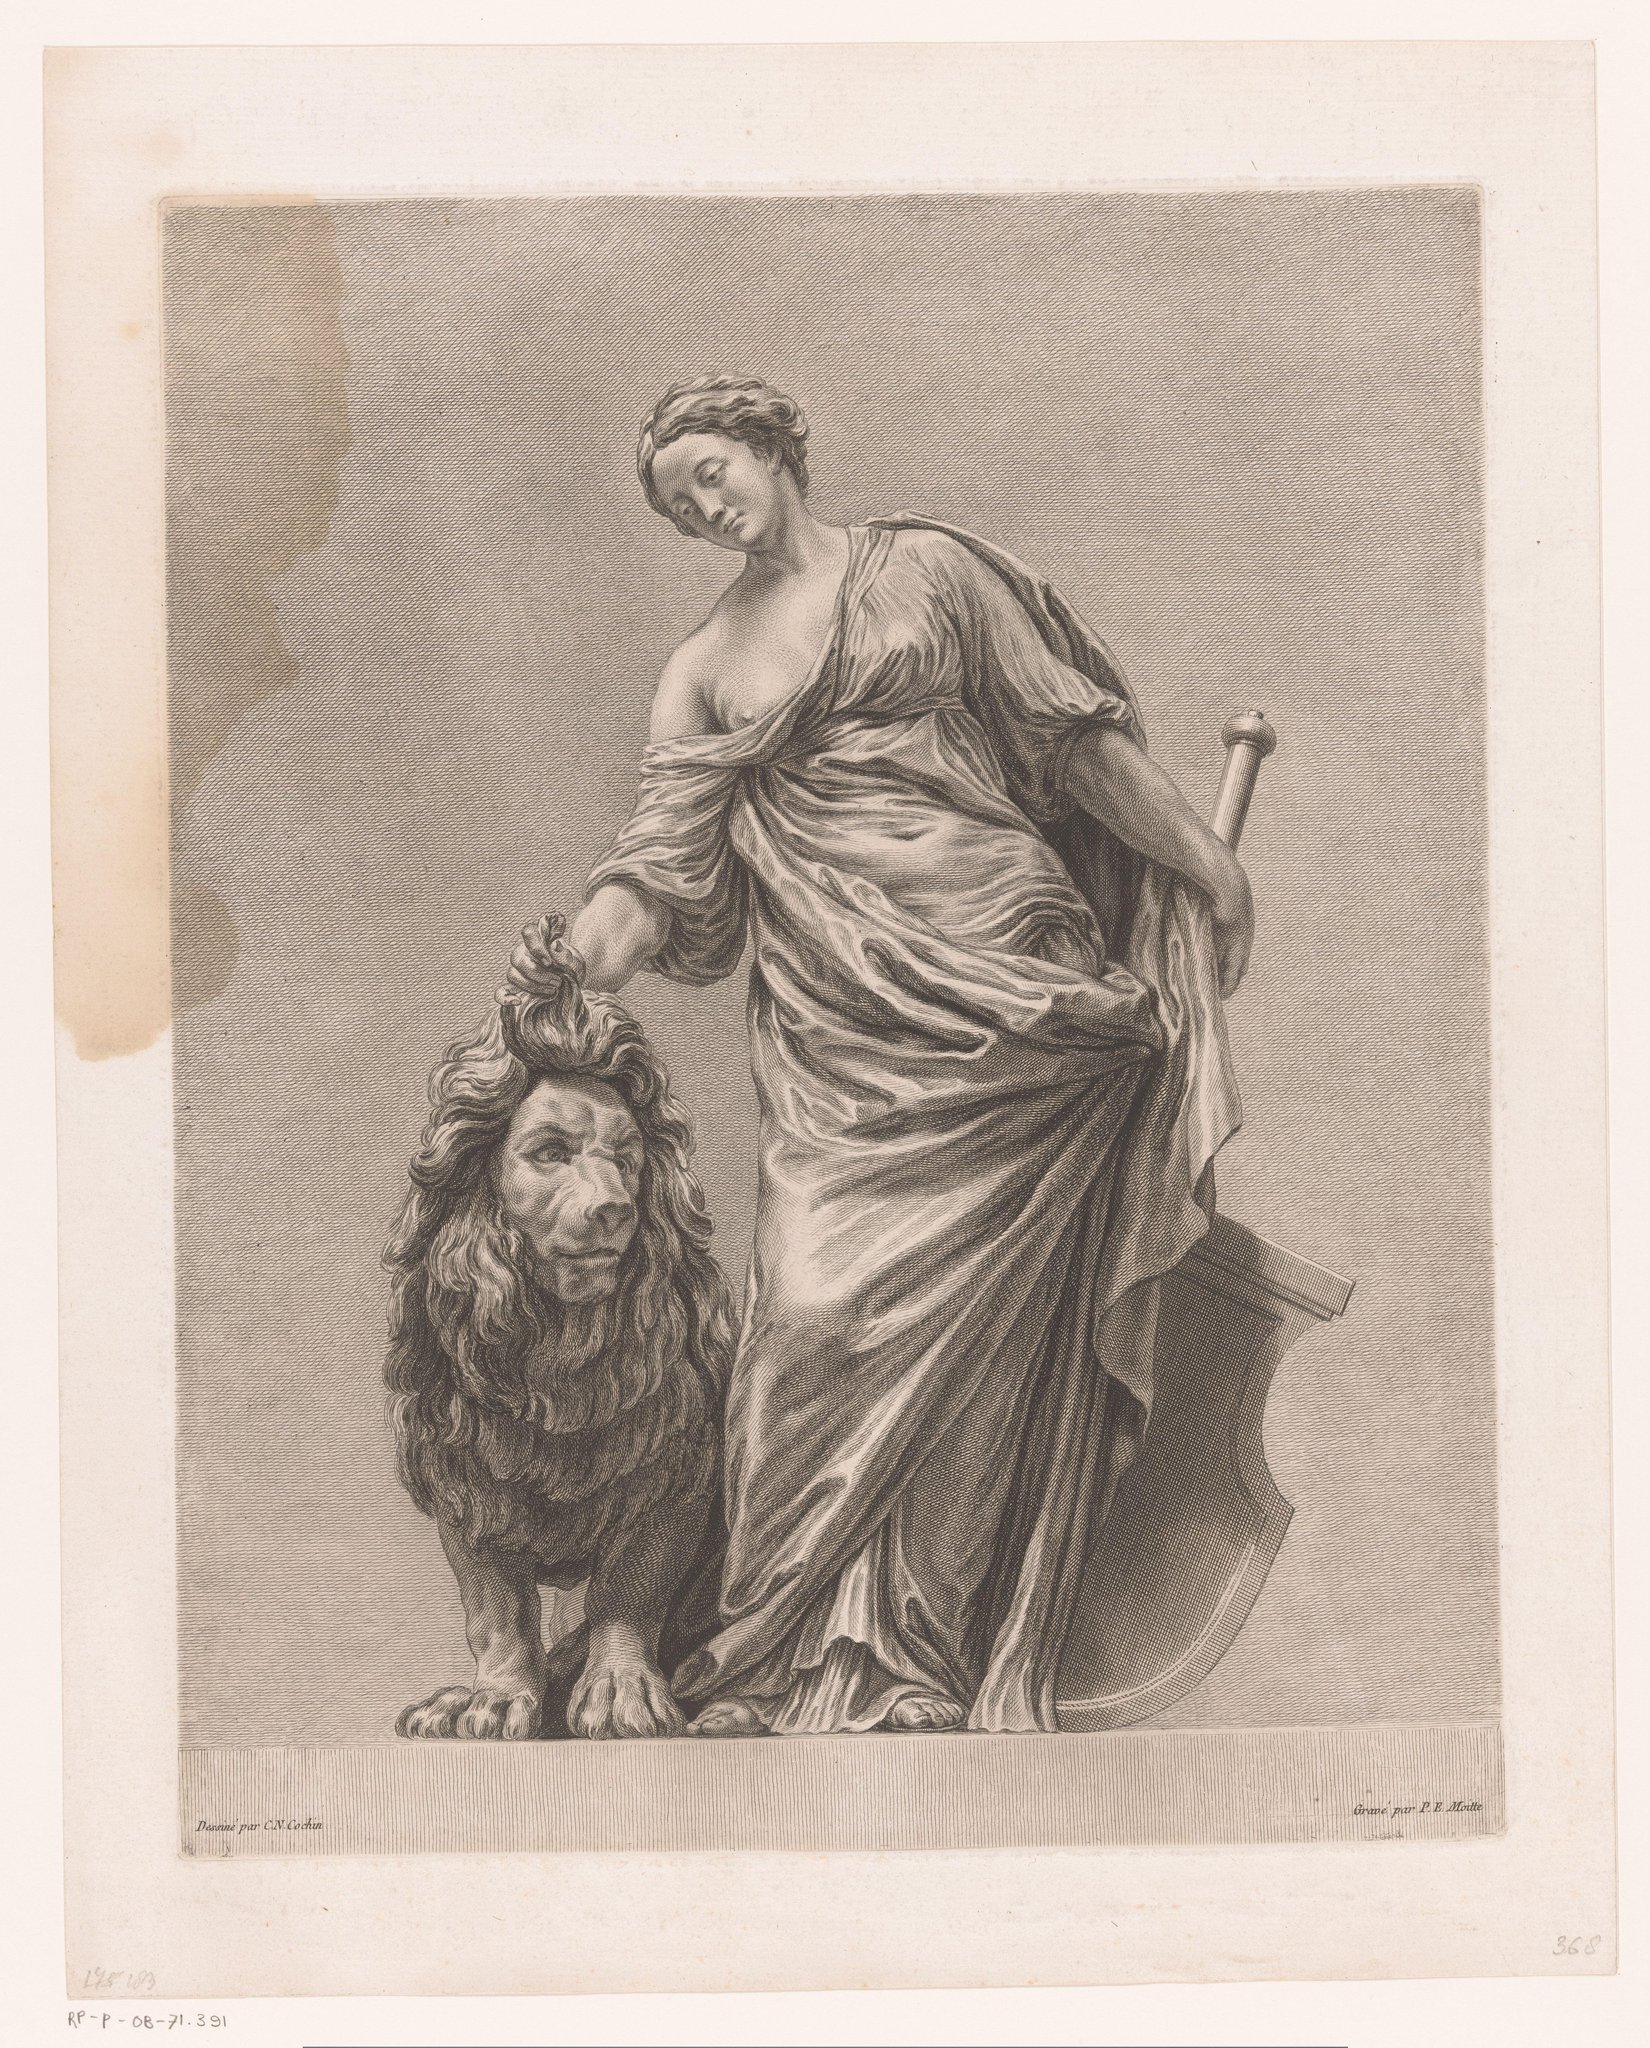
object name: print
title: Vrouw met leeuw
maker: pierre etienne moitte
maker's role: print maker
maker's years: 1722-1780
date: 1732-1780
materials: paper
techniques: engraving, etching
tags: personifications of countries, nations, states, districts, etc., africa represented allegorically; 'africa' (ripa), beasts of prey, predatory animals: lion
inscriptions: collector's mark: Lugt 2228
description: Mogelijk een vrouwelijke personificatie van Afrika of Venetië.